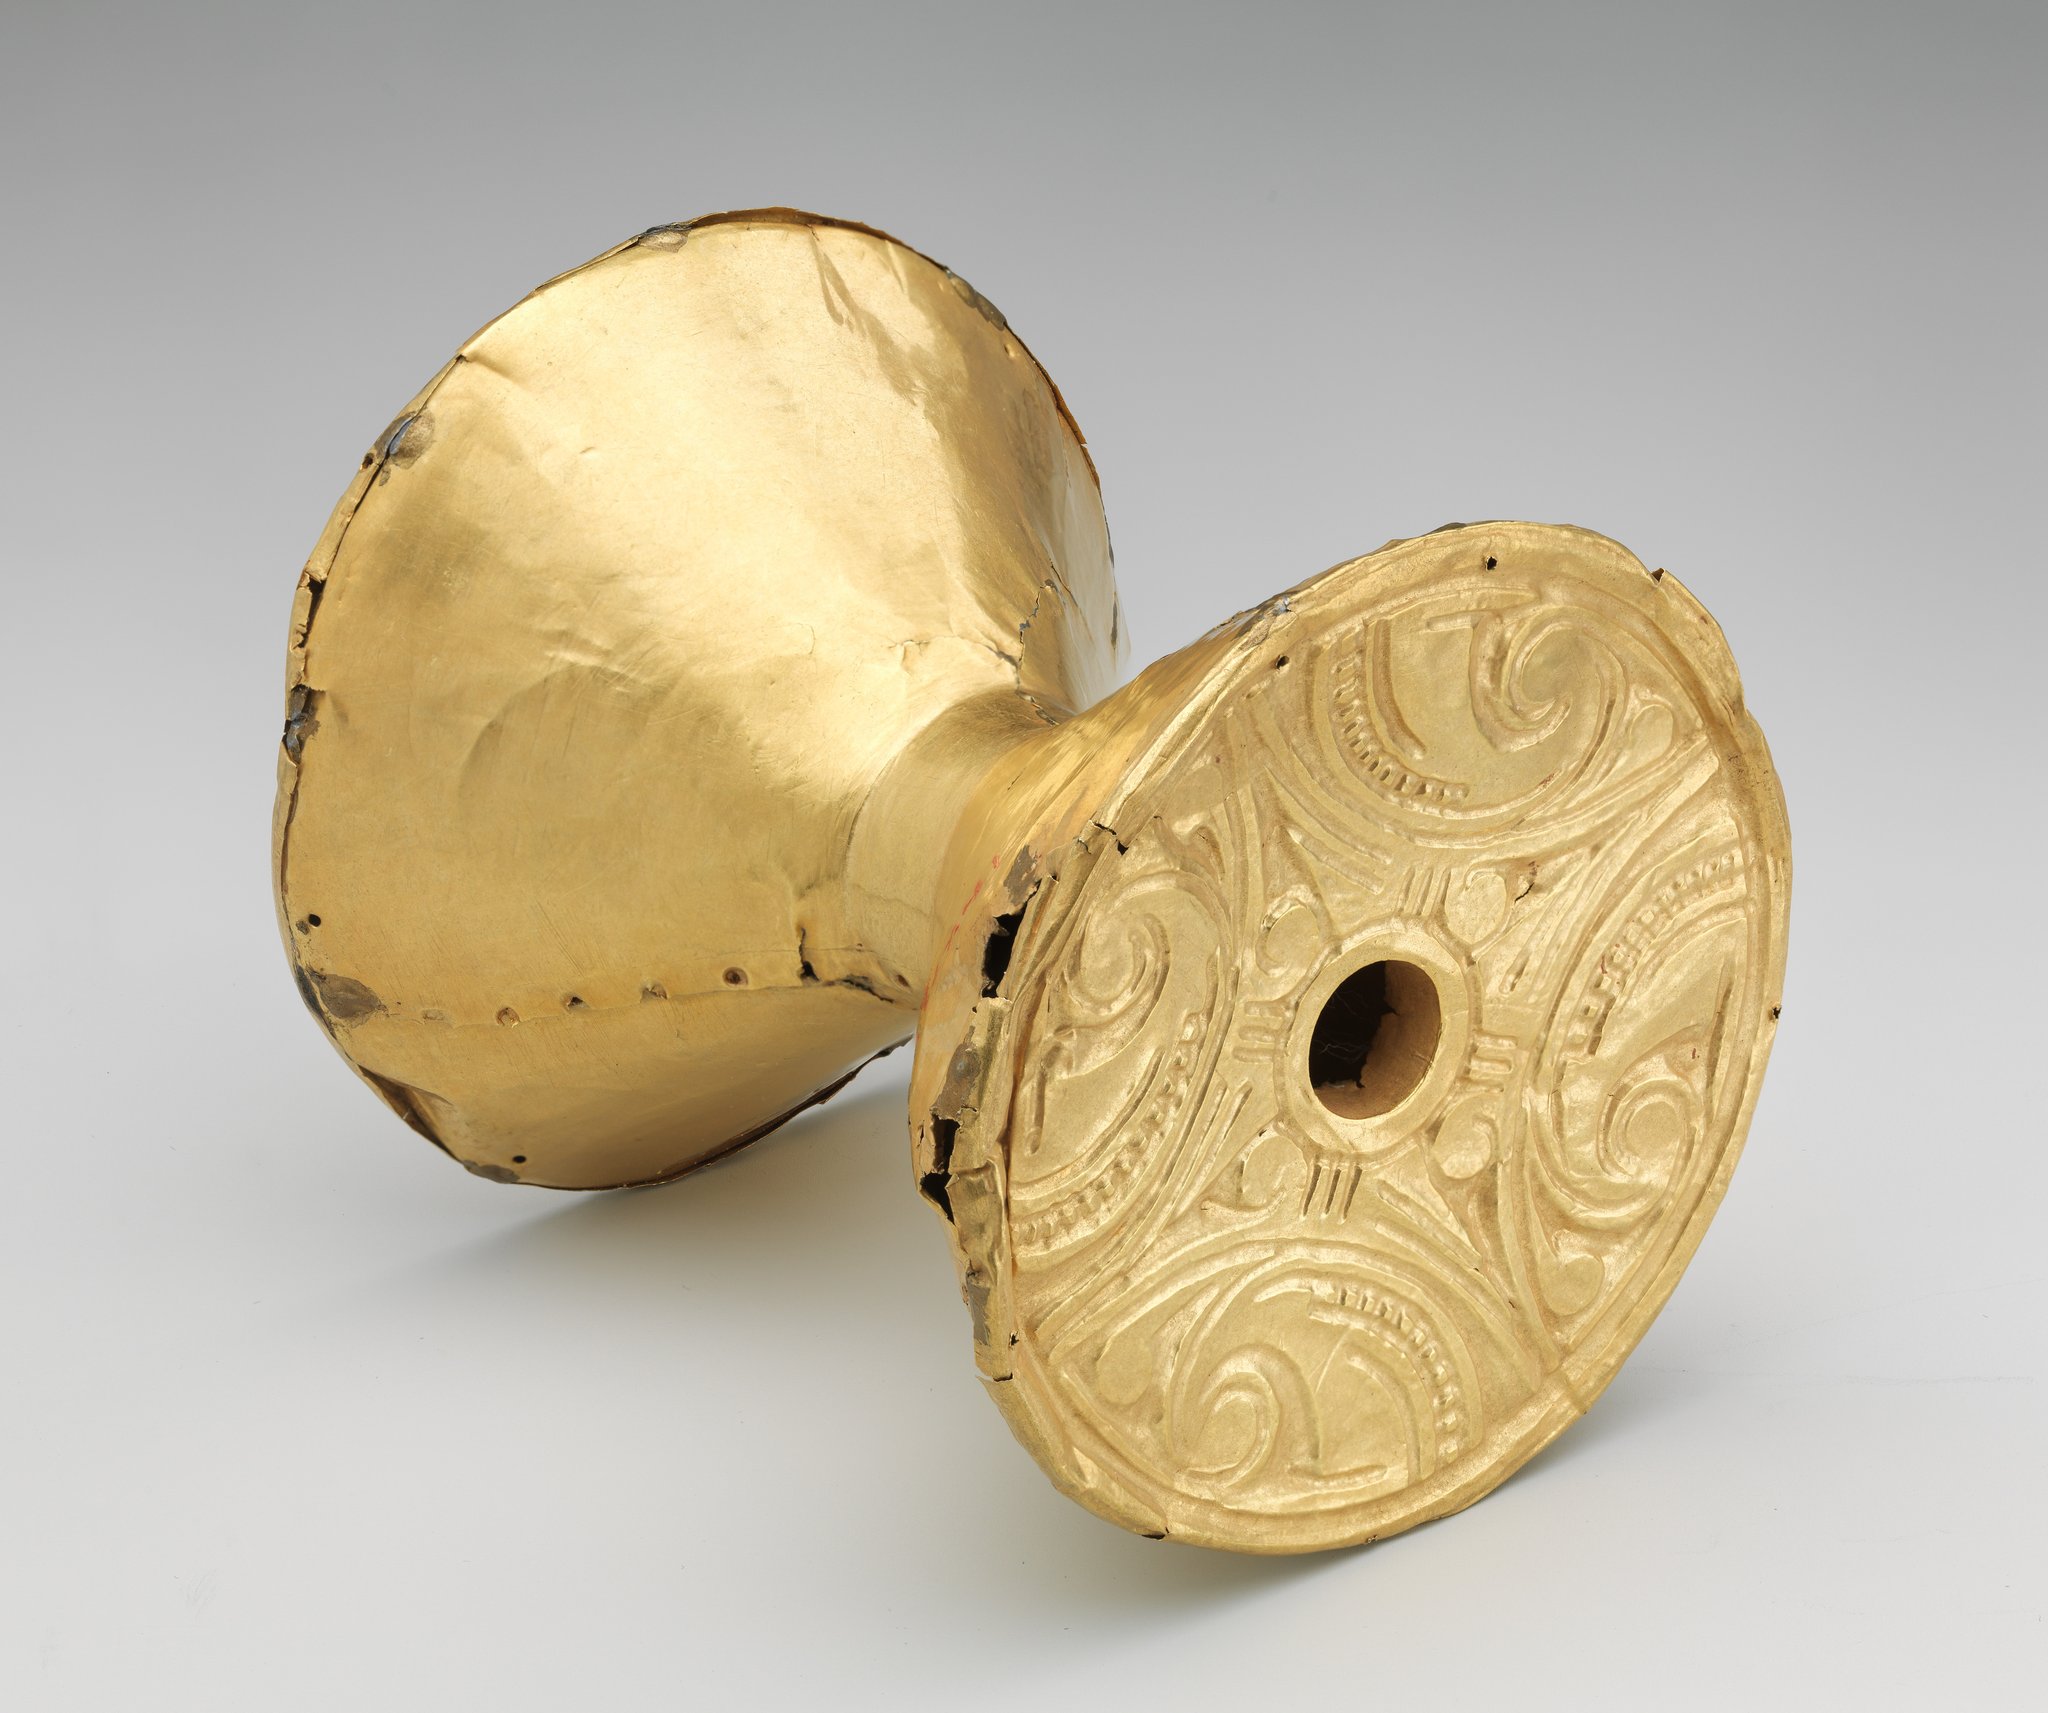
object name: ear spool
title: Earspool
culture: calima-yotoco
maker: calima (yotoco) artist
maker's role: artist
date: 100 BCE-700 CE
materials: gold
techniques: hammering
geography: colombia